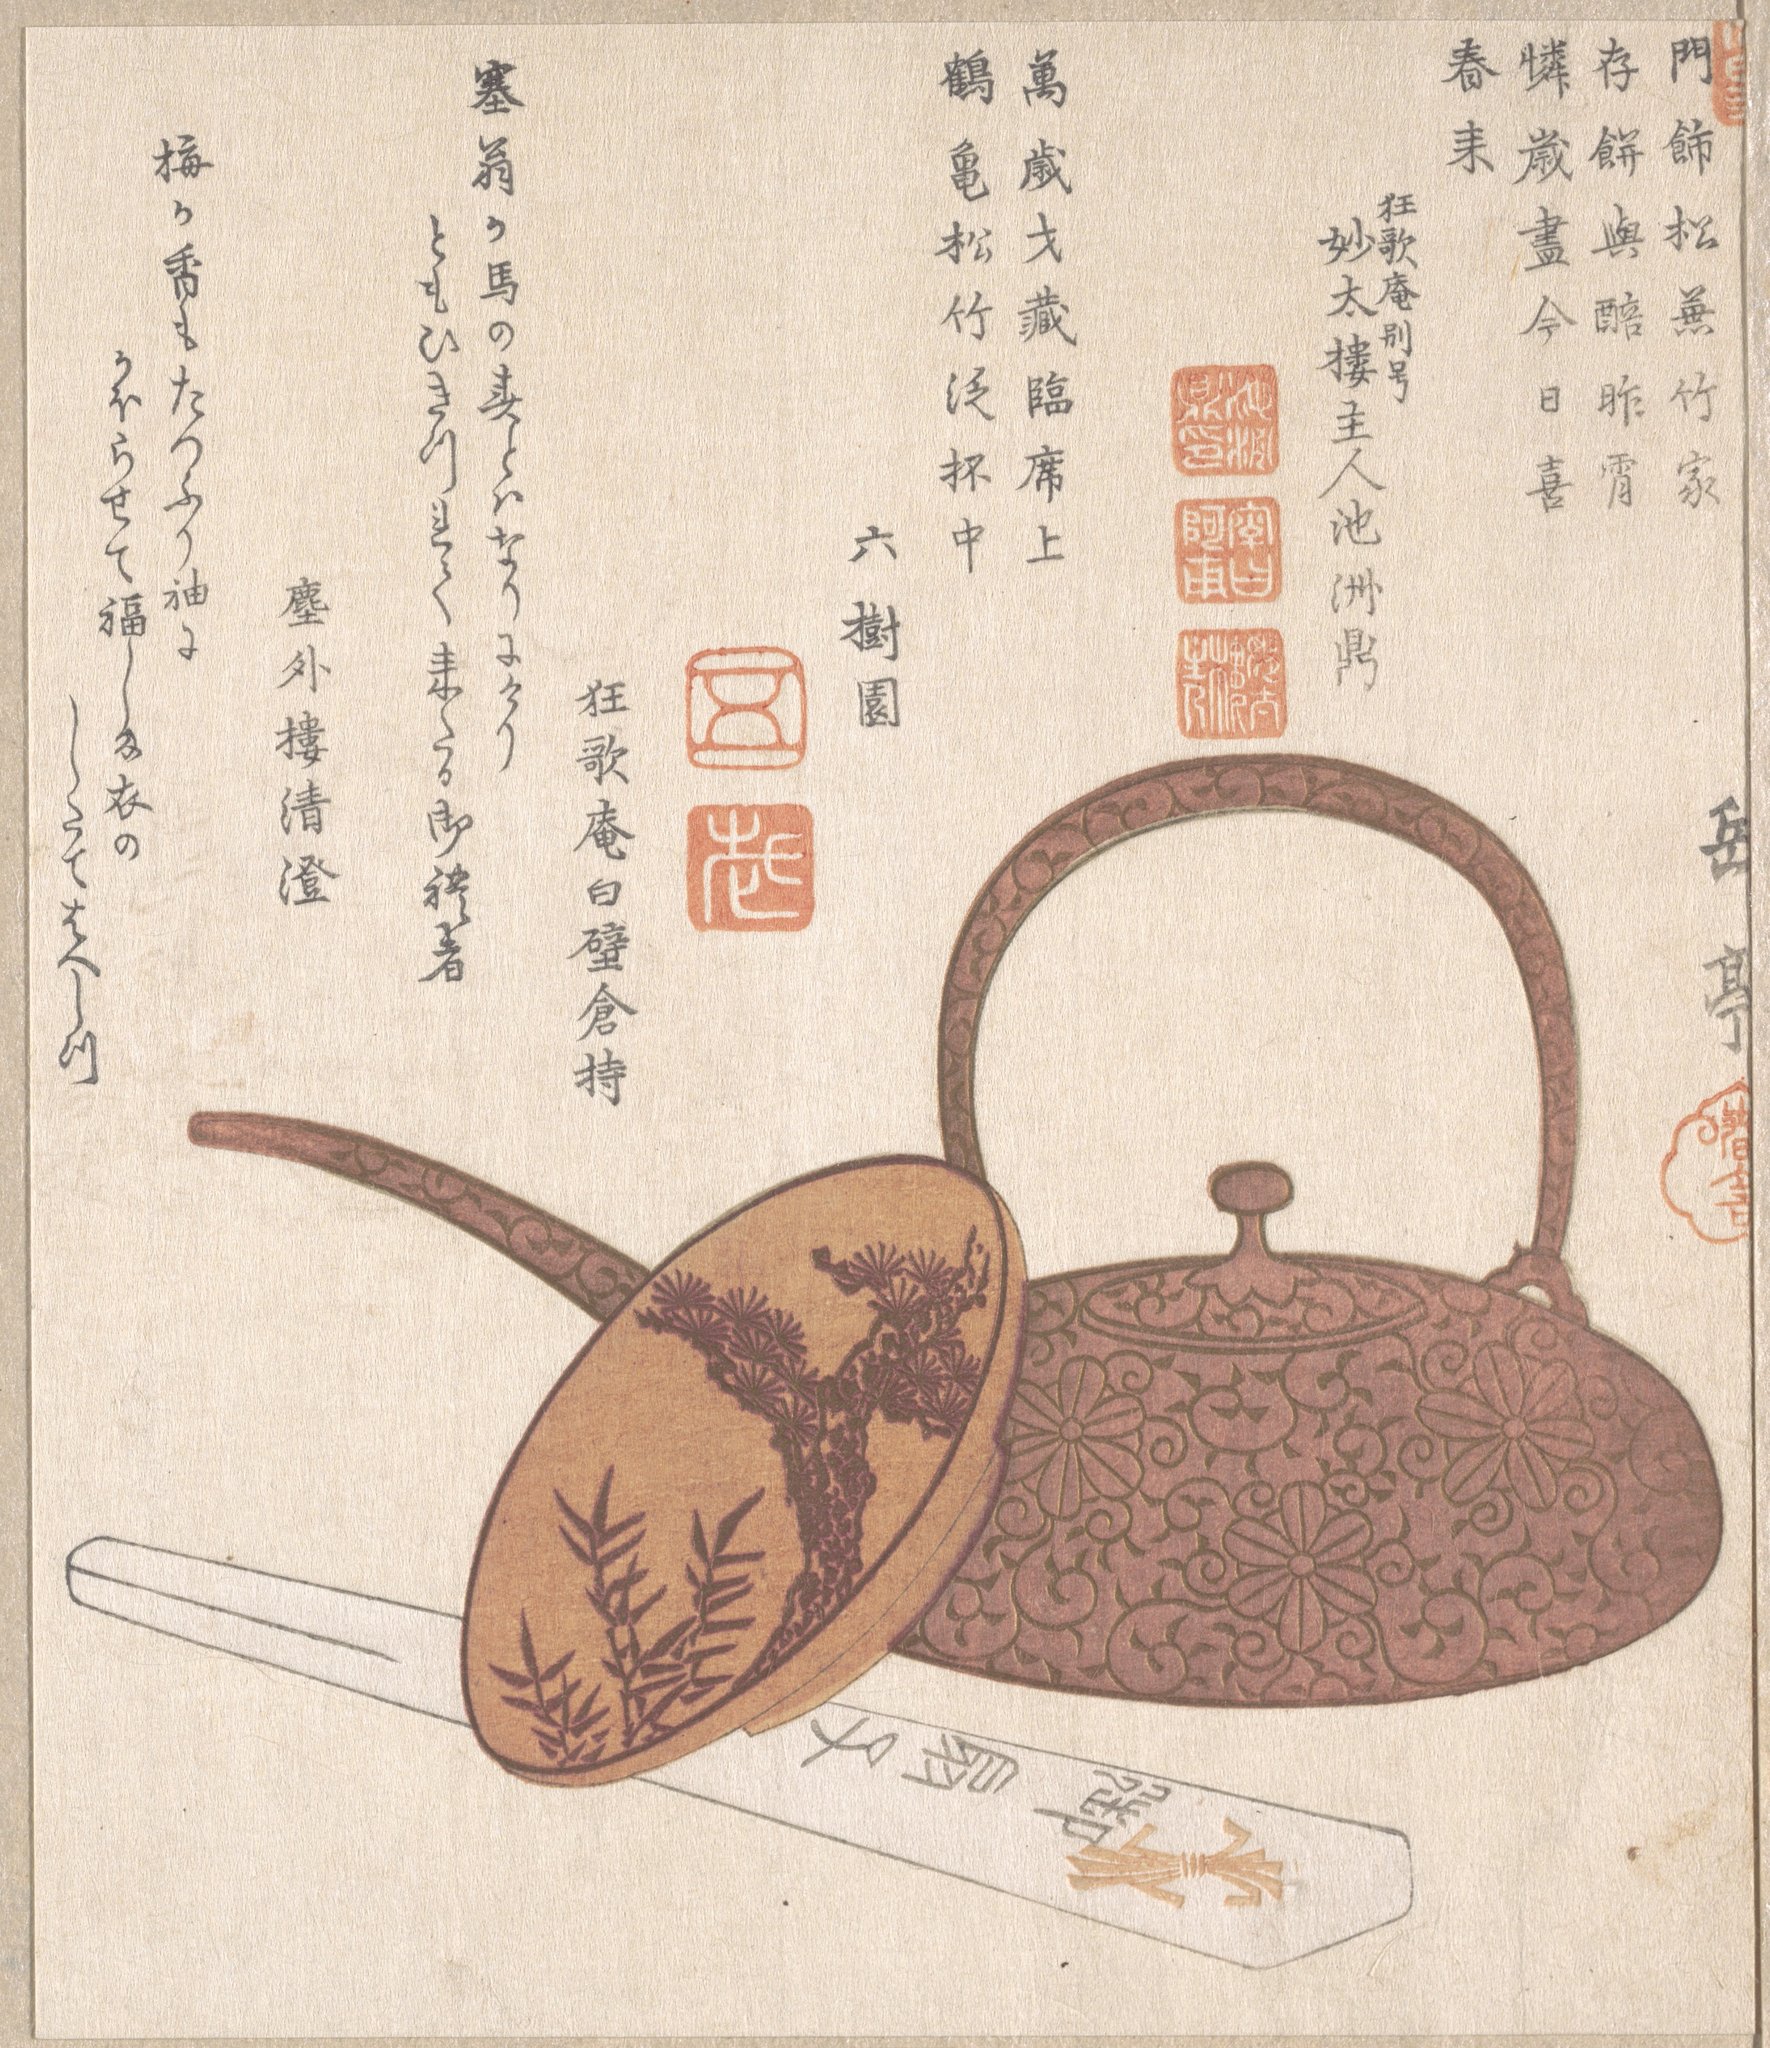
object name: print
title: Wine Pot, Wine Cup and Folded Fan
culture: japanese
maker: yashima gakutei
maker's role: artist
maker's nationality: japanese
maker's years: 1786-1868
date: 1801-1900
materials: ink, paper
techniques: surimono, woodblock print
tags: fans